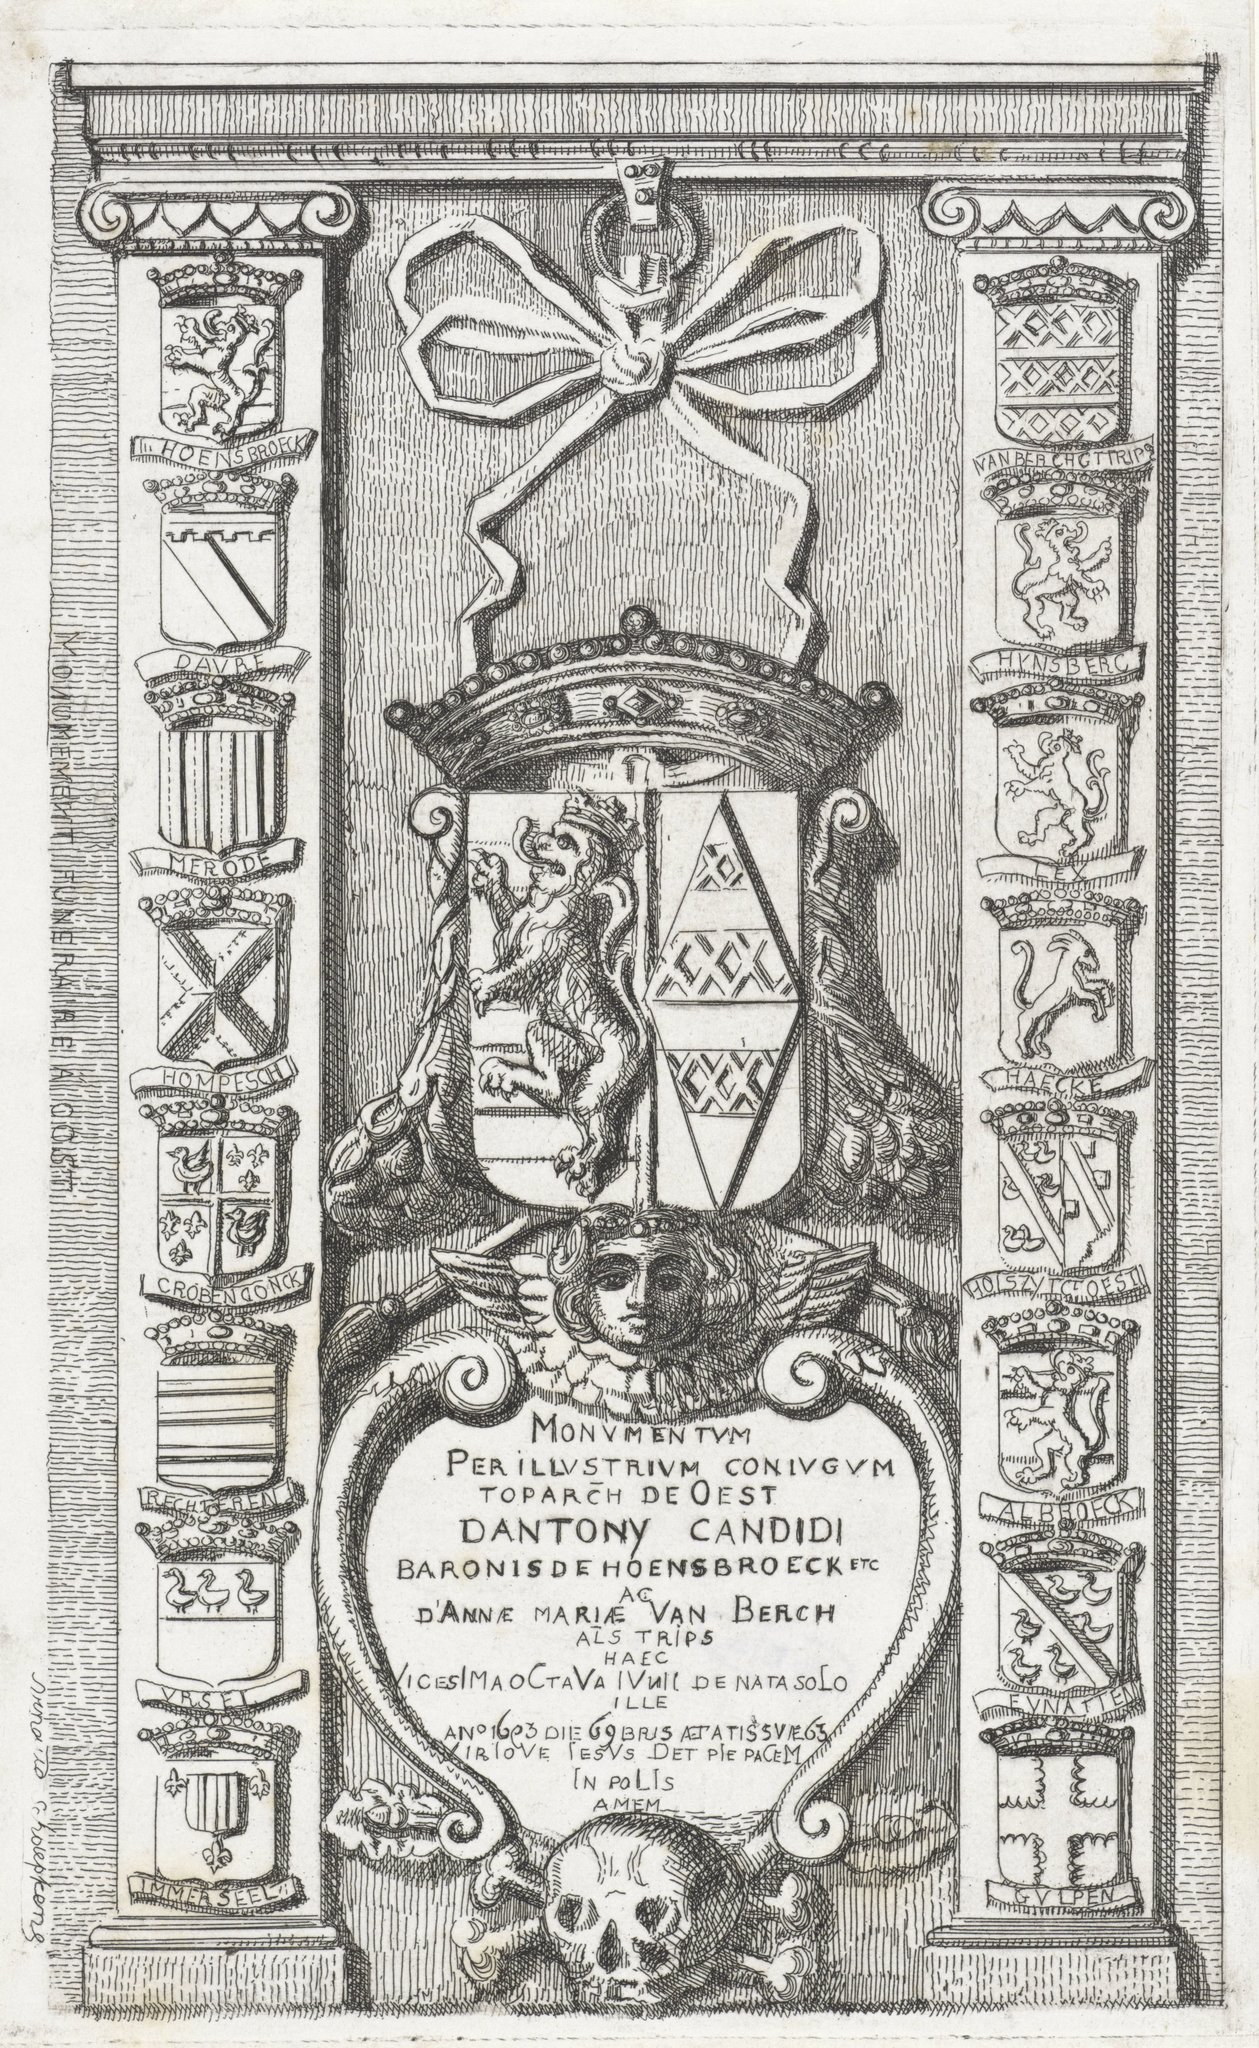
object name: print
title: Grafmonument van Anthonius Candidus de Hoensbroeck-Geul en Anna Maria van Berghe, alias Trips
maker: arnoud schaepkens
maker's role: print maker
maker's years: 1816-1904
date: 1831-1904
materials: paper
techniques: etching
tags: epitaph, armorial bearing, heraldry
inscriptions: collector's mark: Lugt 2228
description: Tussen twee pilasters met wapenschilden een cartouche met een opschrift in het Latijn. Rond de cartouche een cherubijn en een doodskop. Daarboven aan een lint het wapenschild van de overledenen.